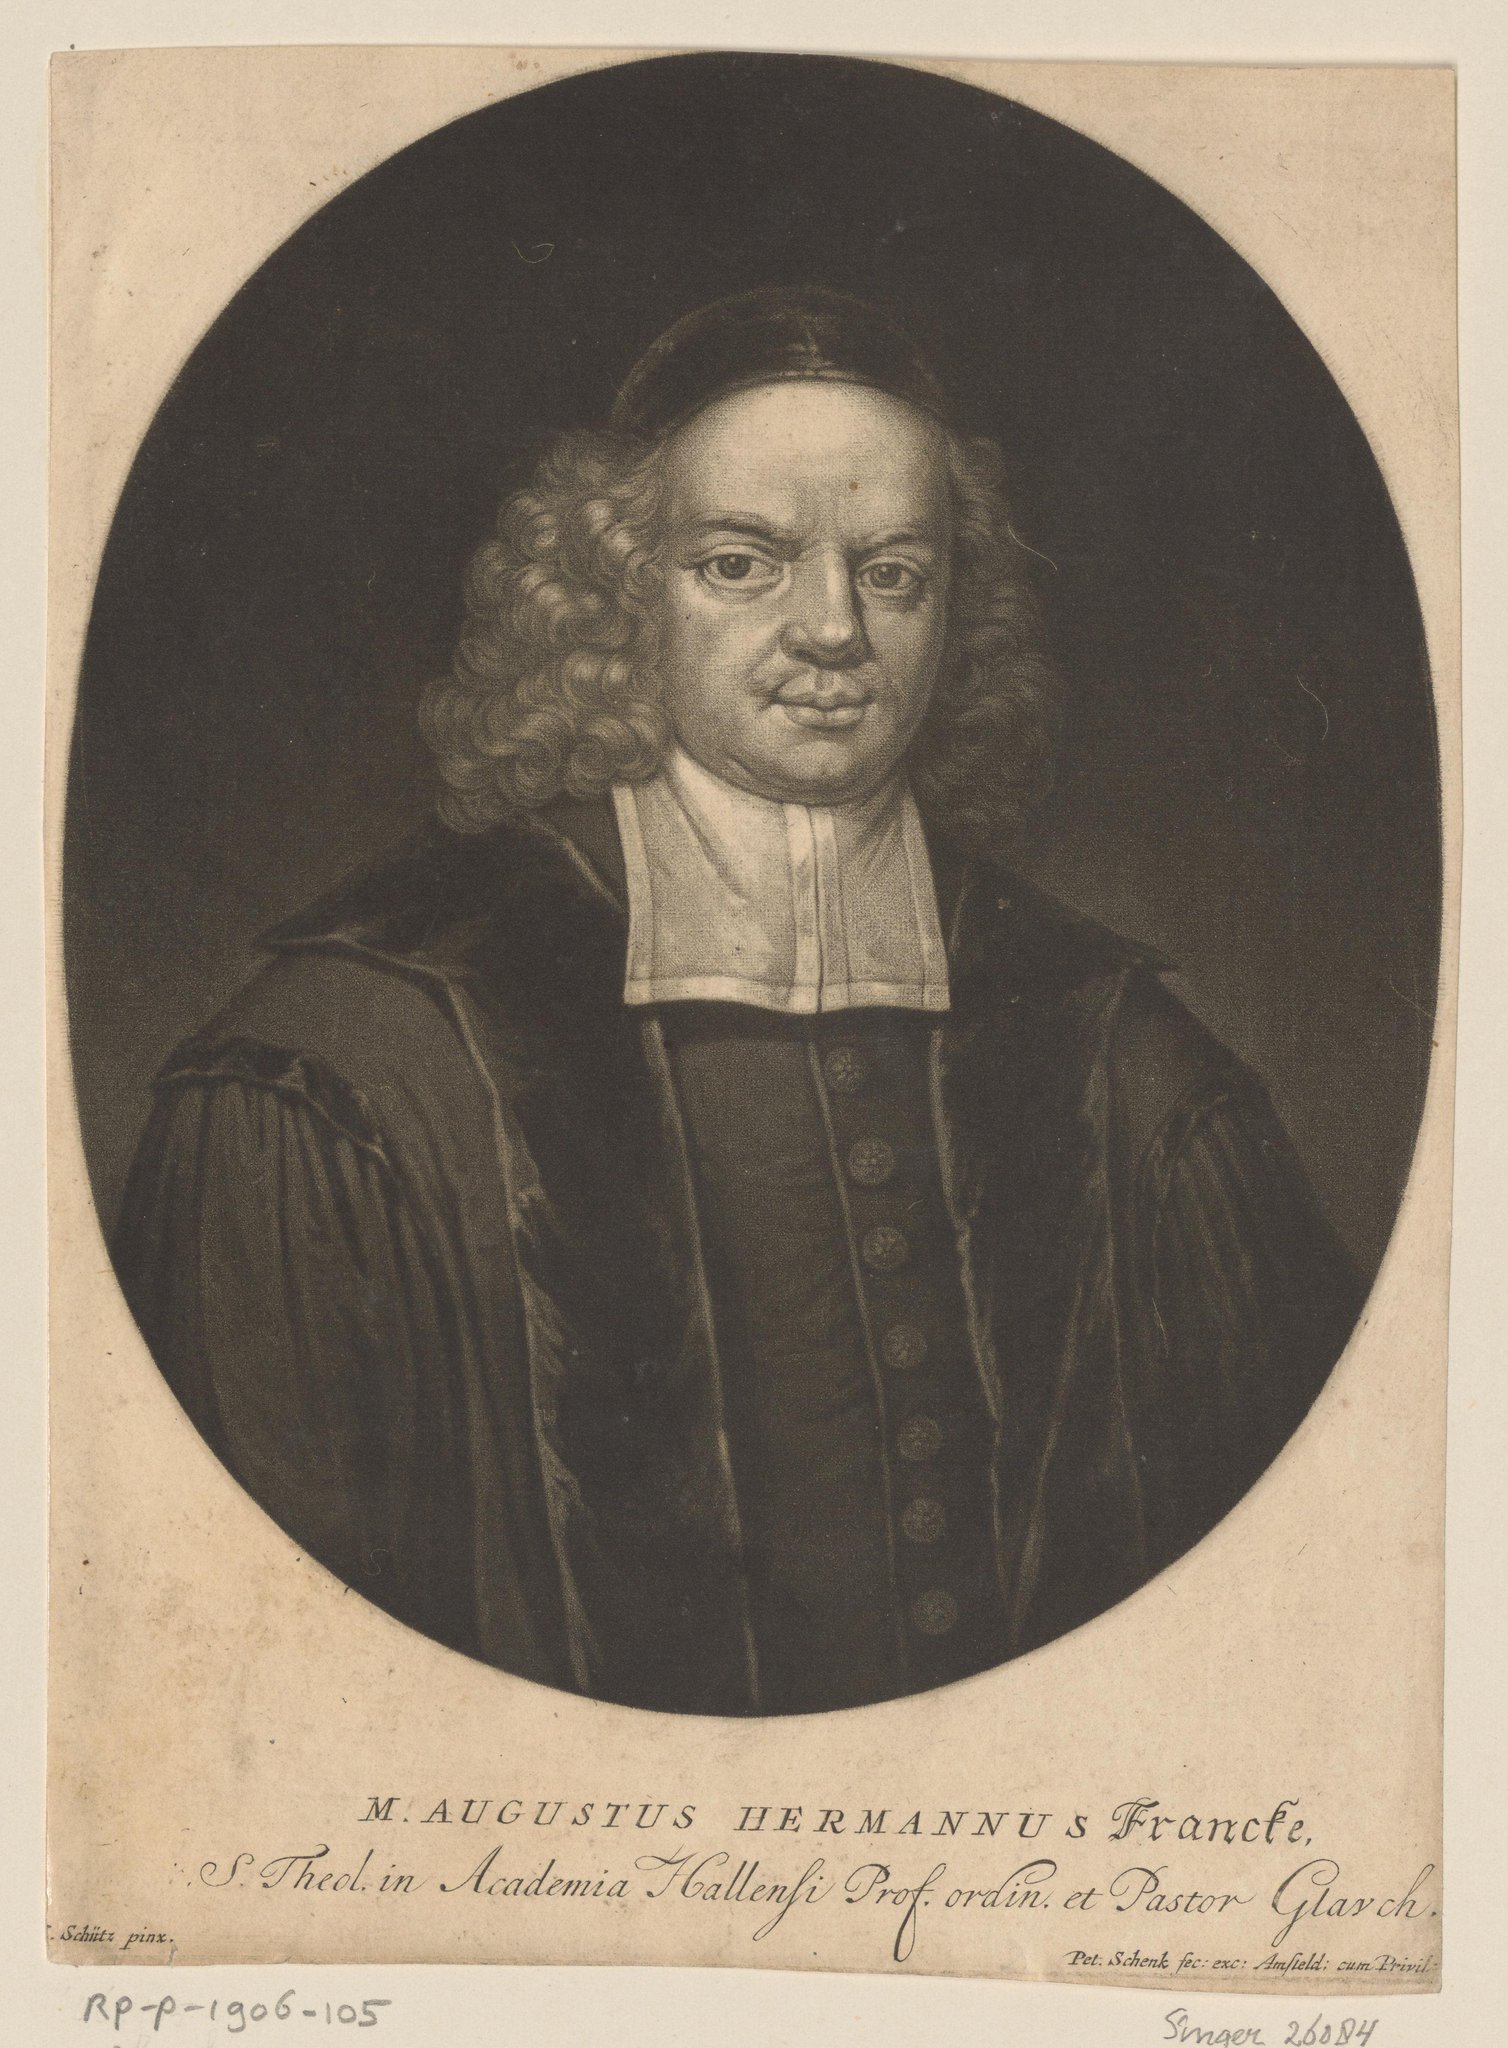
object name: print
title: Portret van August Hermann Francke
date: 1691-1713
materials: paper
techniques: mezzotint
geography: amsterdam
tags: theologian, historical persons, professor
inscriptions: collector's mark: Lugt 2228